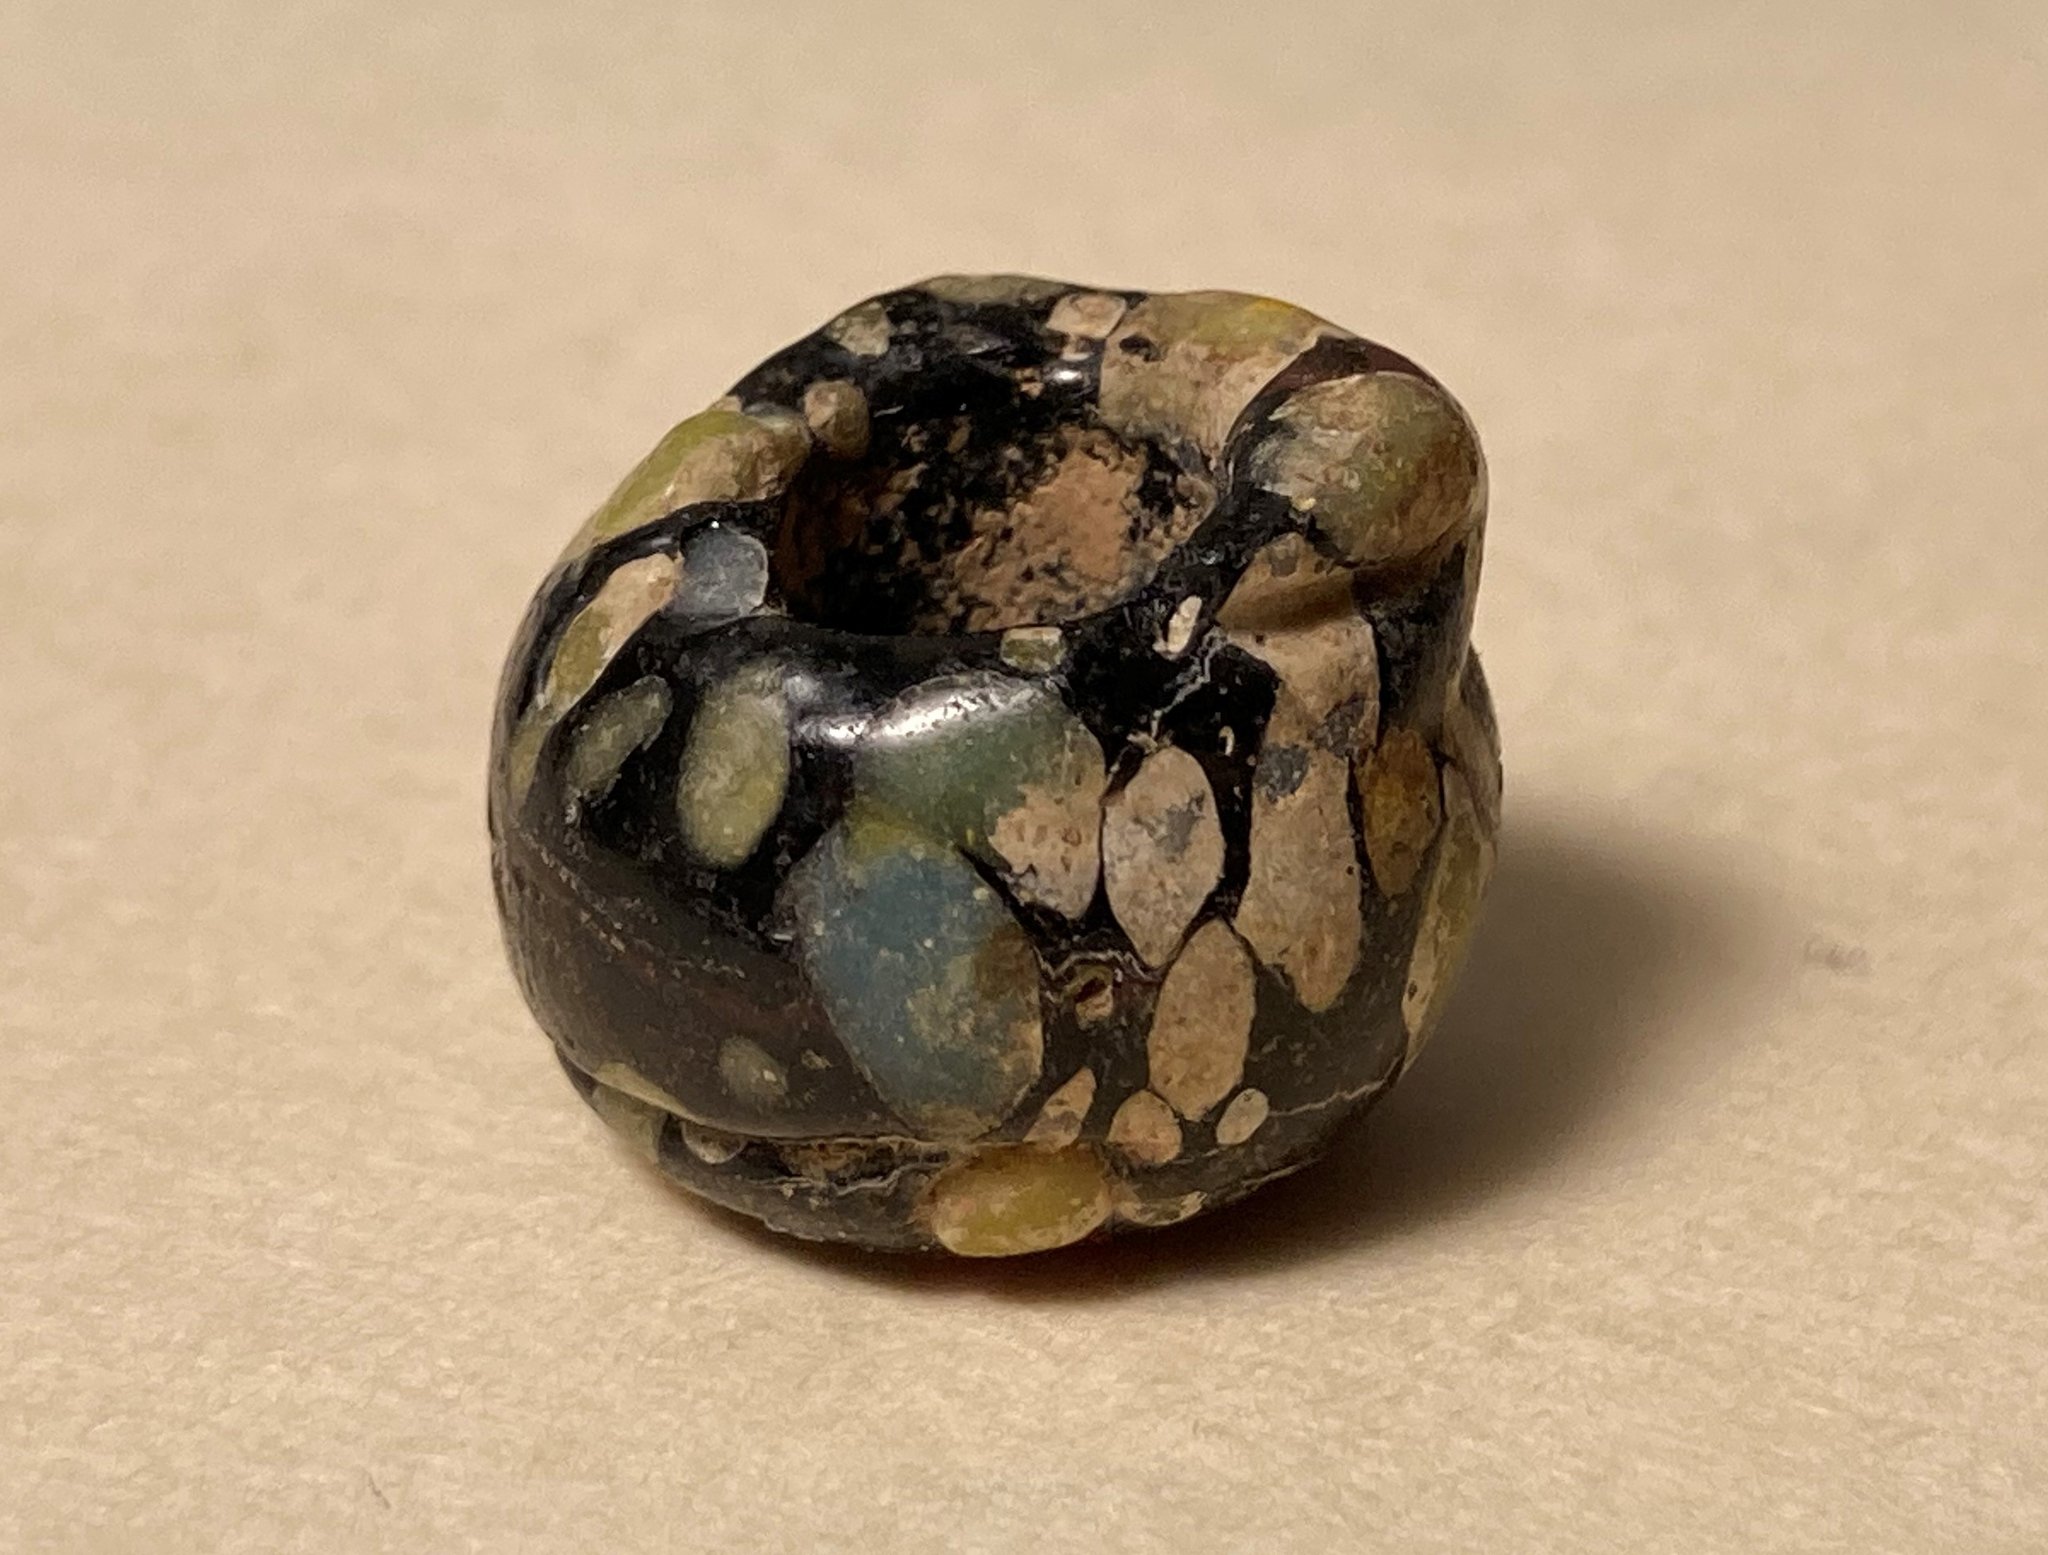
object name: bead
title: Beads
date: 701-1000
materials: glass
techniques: luster painting, stain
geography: iran